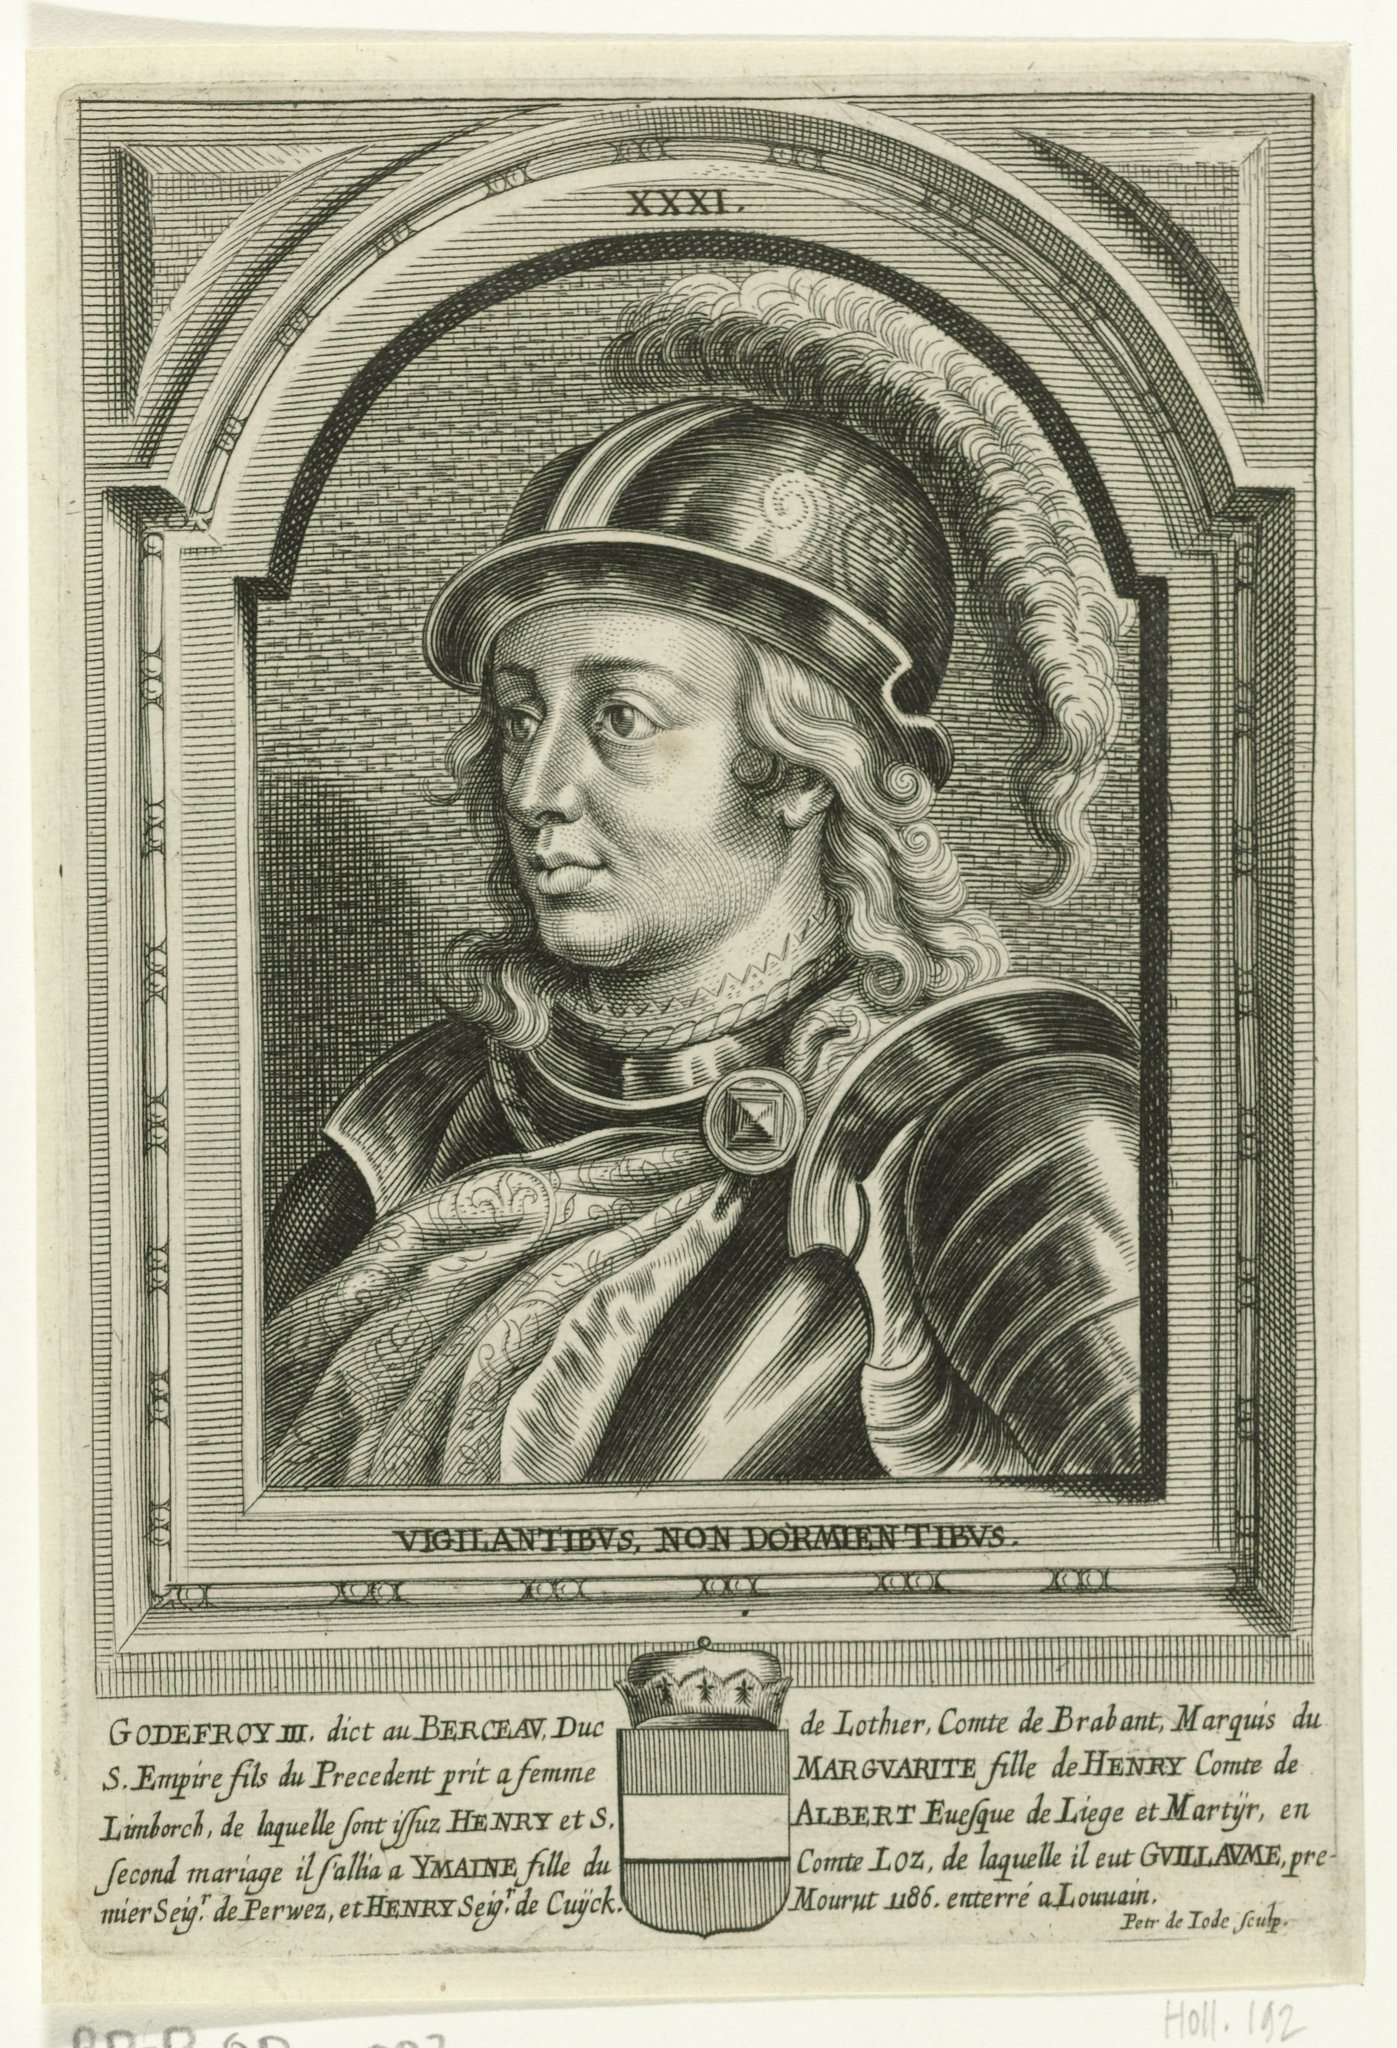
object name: book illustration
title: Portret van Godfried III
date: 1661-1663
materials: paper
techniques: engraving, etching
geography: antwerp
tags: armour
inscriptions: collector's mark: Lugt 2228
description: Busteportret van Godfried III, in harnas. Hij draagt een helm met pluim. Het portret is gevat in een boogvormige omlijsting met vierkant randwerk en een motto in het Latijn. In de marge het wapenschild van de geportretteerde en een vijfregelig onderschrift in het Frans. Prent uit een boek waarin 54 prenten met portretten.